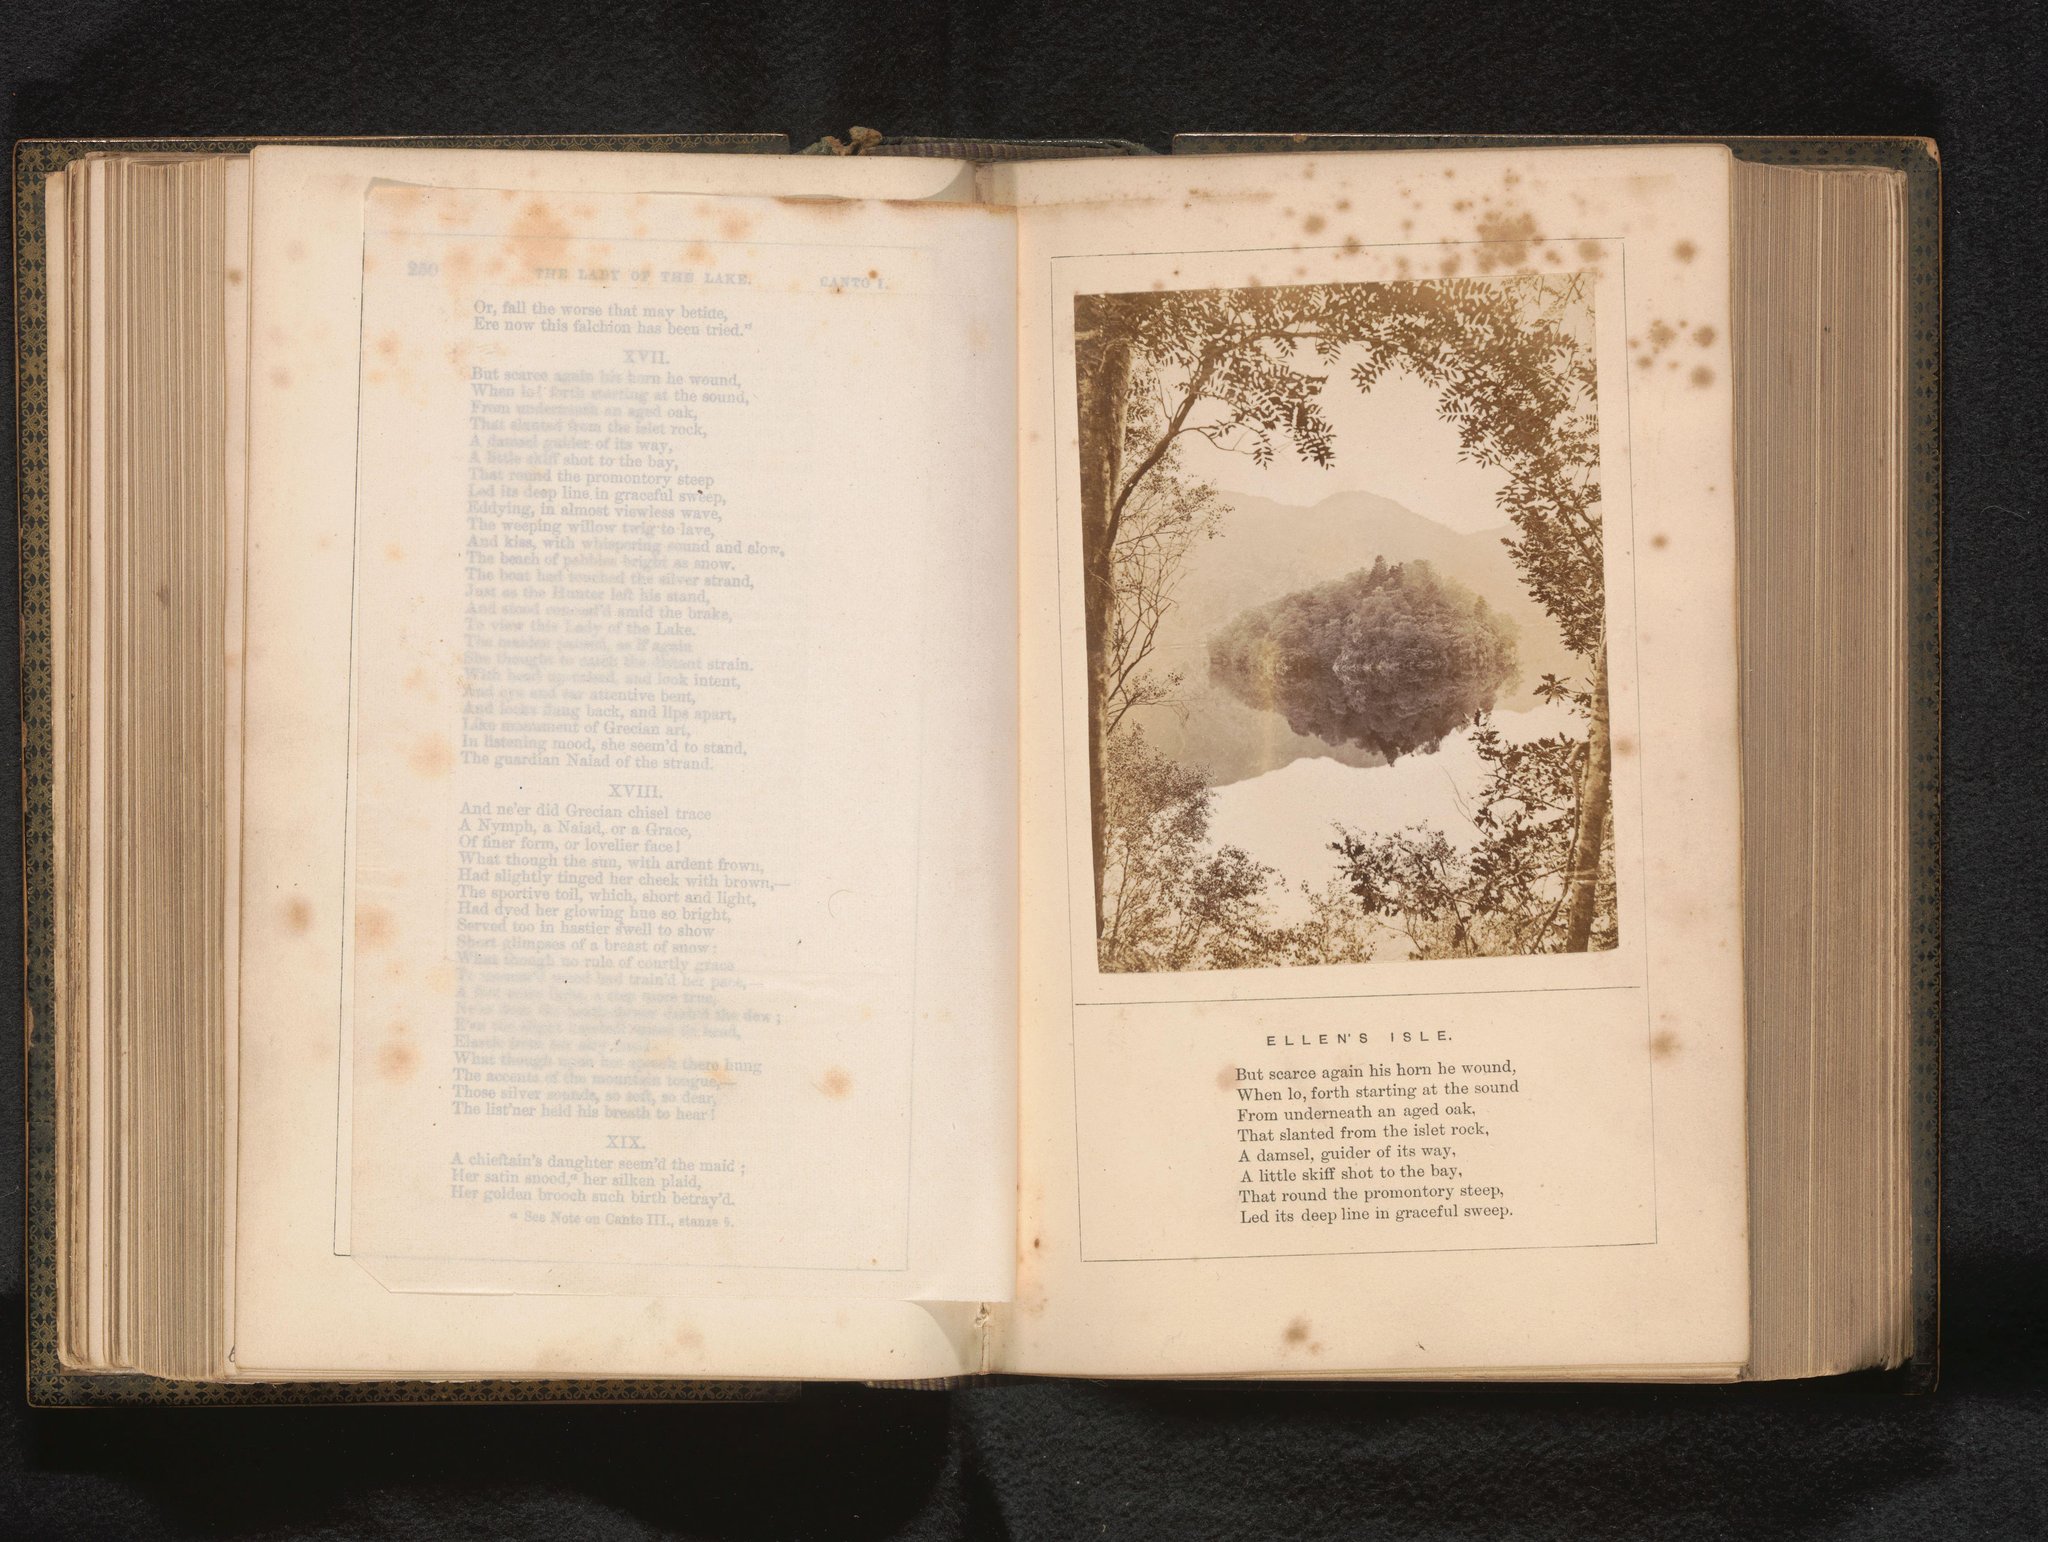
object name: page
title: Ellen's Isle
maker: Anonymous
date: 1858-1868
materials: photographic support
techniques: albumen print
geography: loch katrine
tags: island, lake - hh - ideal landscapes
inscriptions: inscription: ‘But scarce again his horn he wound, When le, forth starting at the sound (...)’